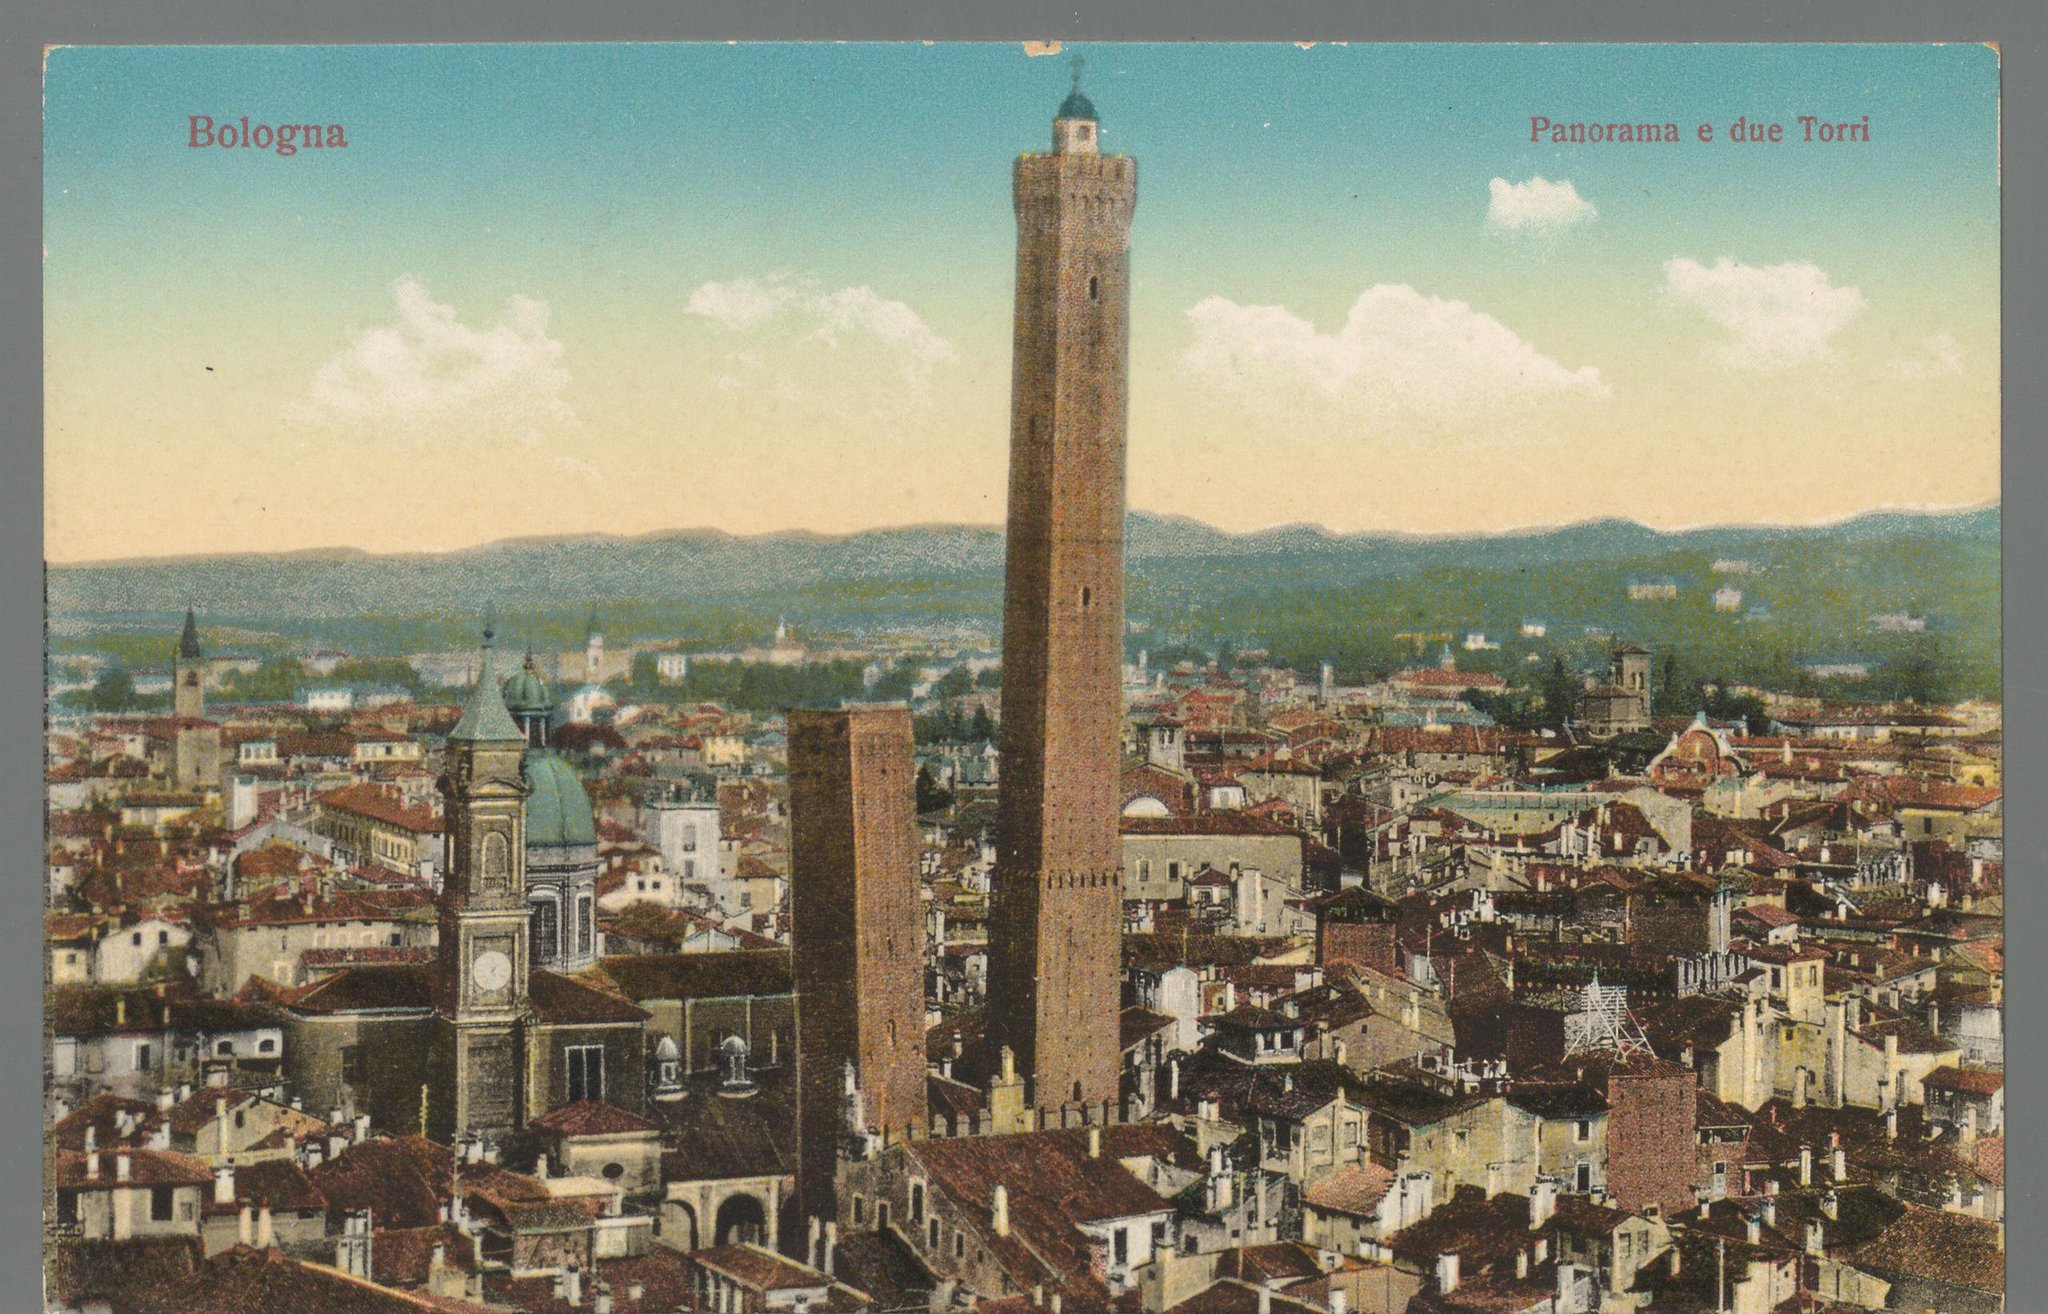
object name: ansichtkaart, prentbriefkaart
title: Bologna. Panorama e due Torri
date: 1905-1930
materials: cardboard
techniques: photograph, lithograph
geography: zurich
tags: tower, clock tower ~ monumental adornment, prospect of city, town panorama, silhouette of city